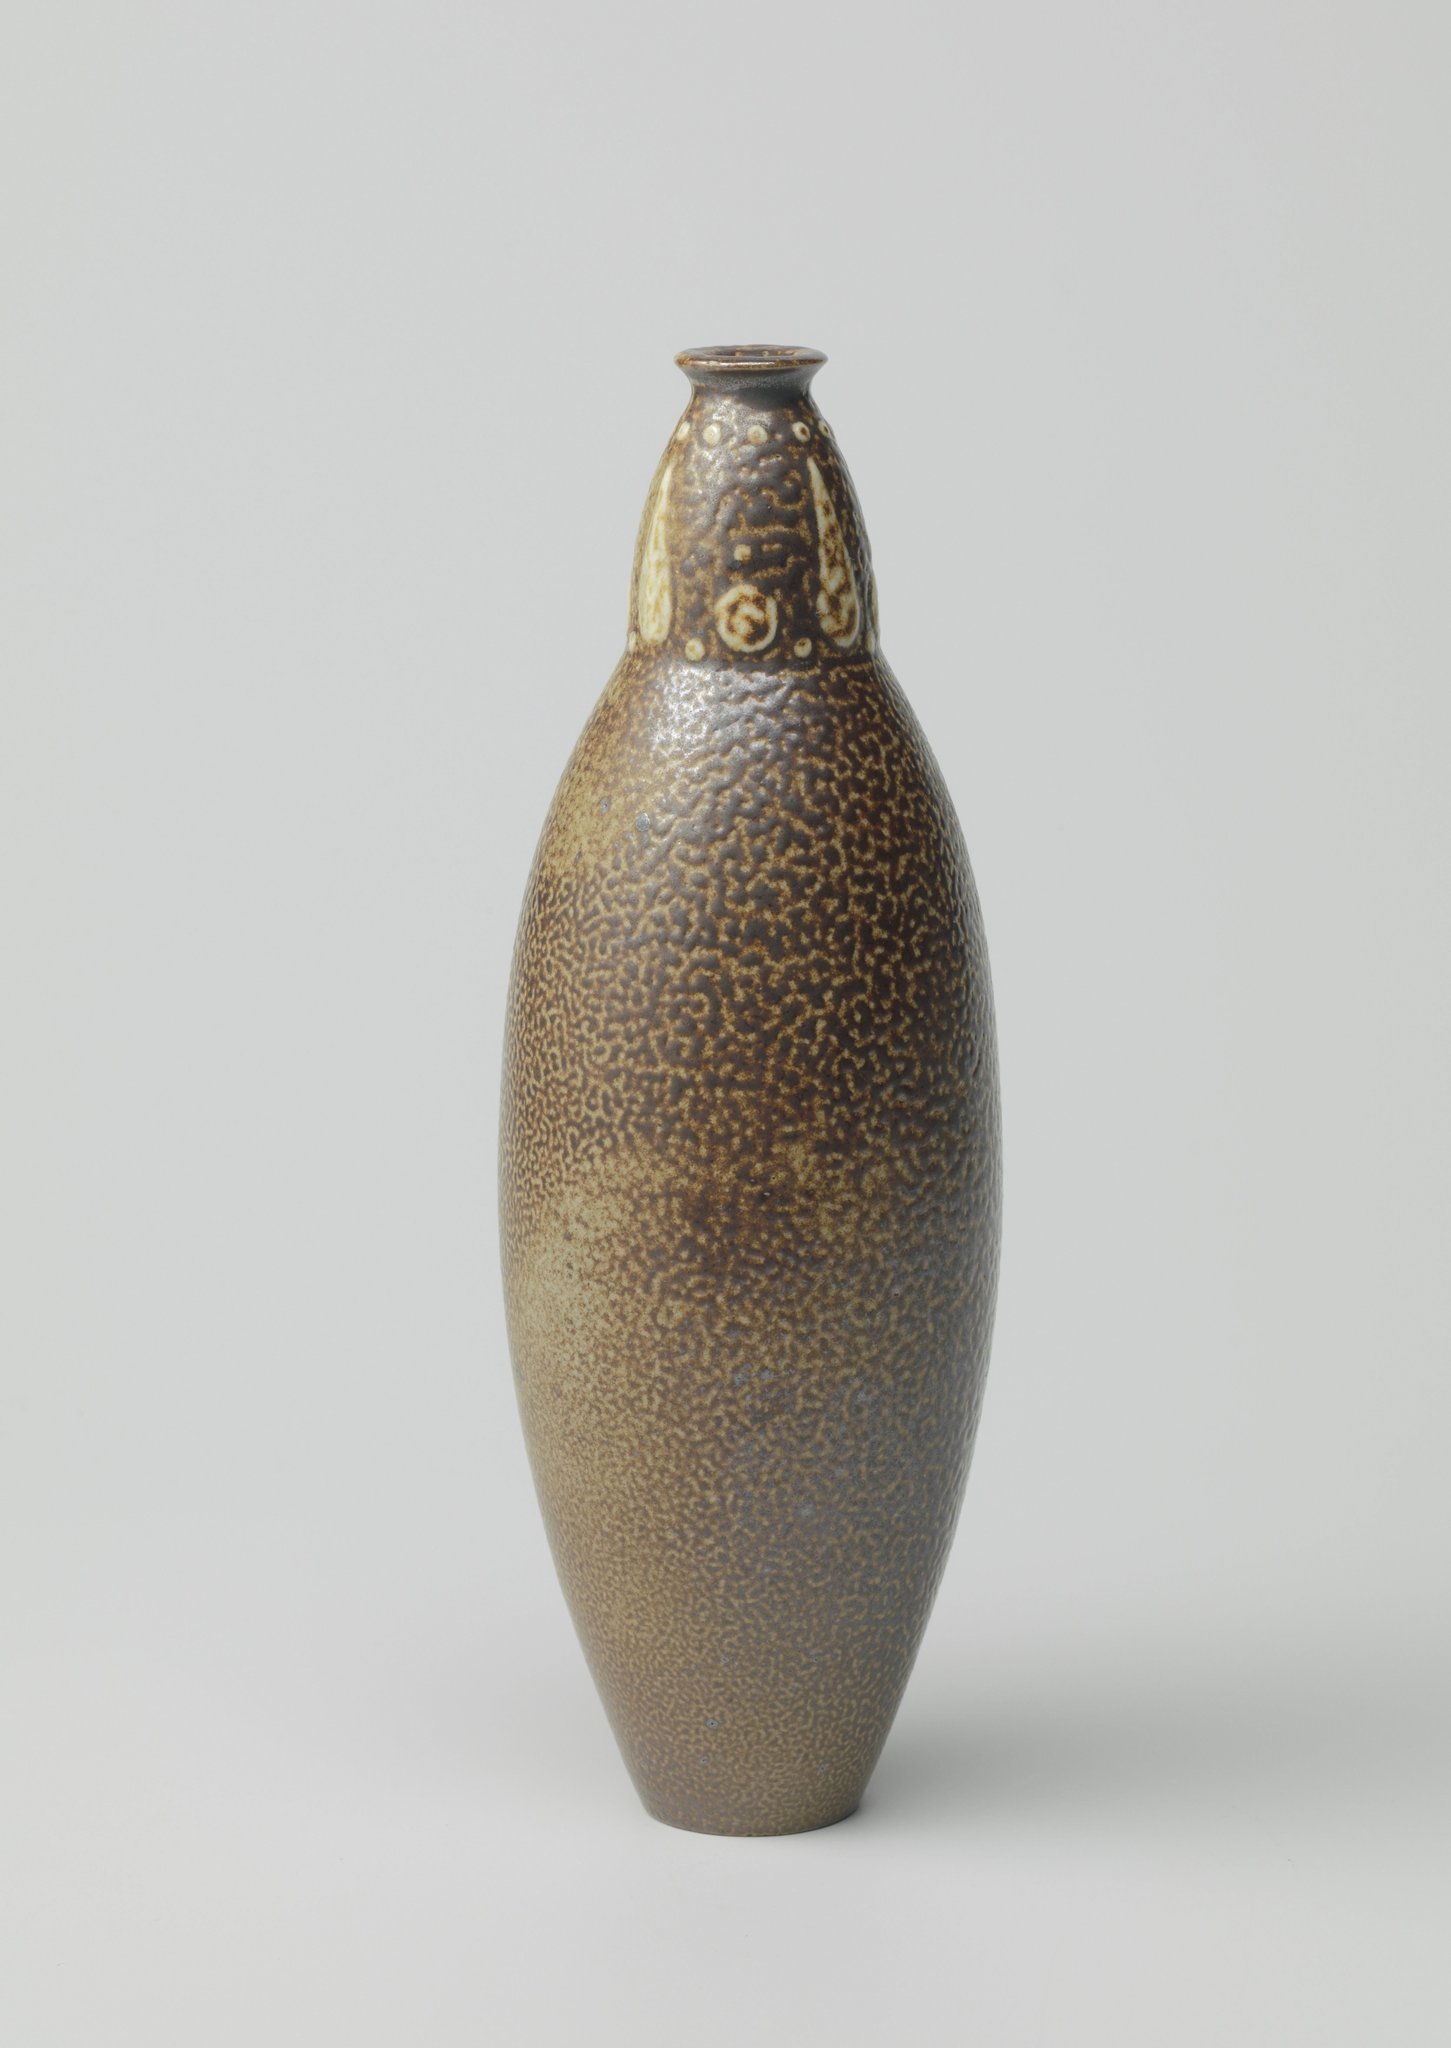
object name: vase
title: Vase with a Salt Glaze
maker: Anonymous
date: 1910-1915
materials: stoneware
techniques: vitrification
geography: meudon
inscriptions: signature: ‘HSim in zwart’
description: Vaas van steengoed, bedekt met zoutglazuur. De hals is versierd met witte cirkels, stippen en spitstoelopende langwerpige vormen in reliëf. Gemerkt met: HSim in zwart.